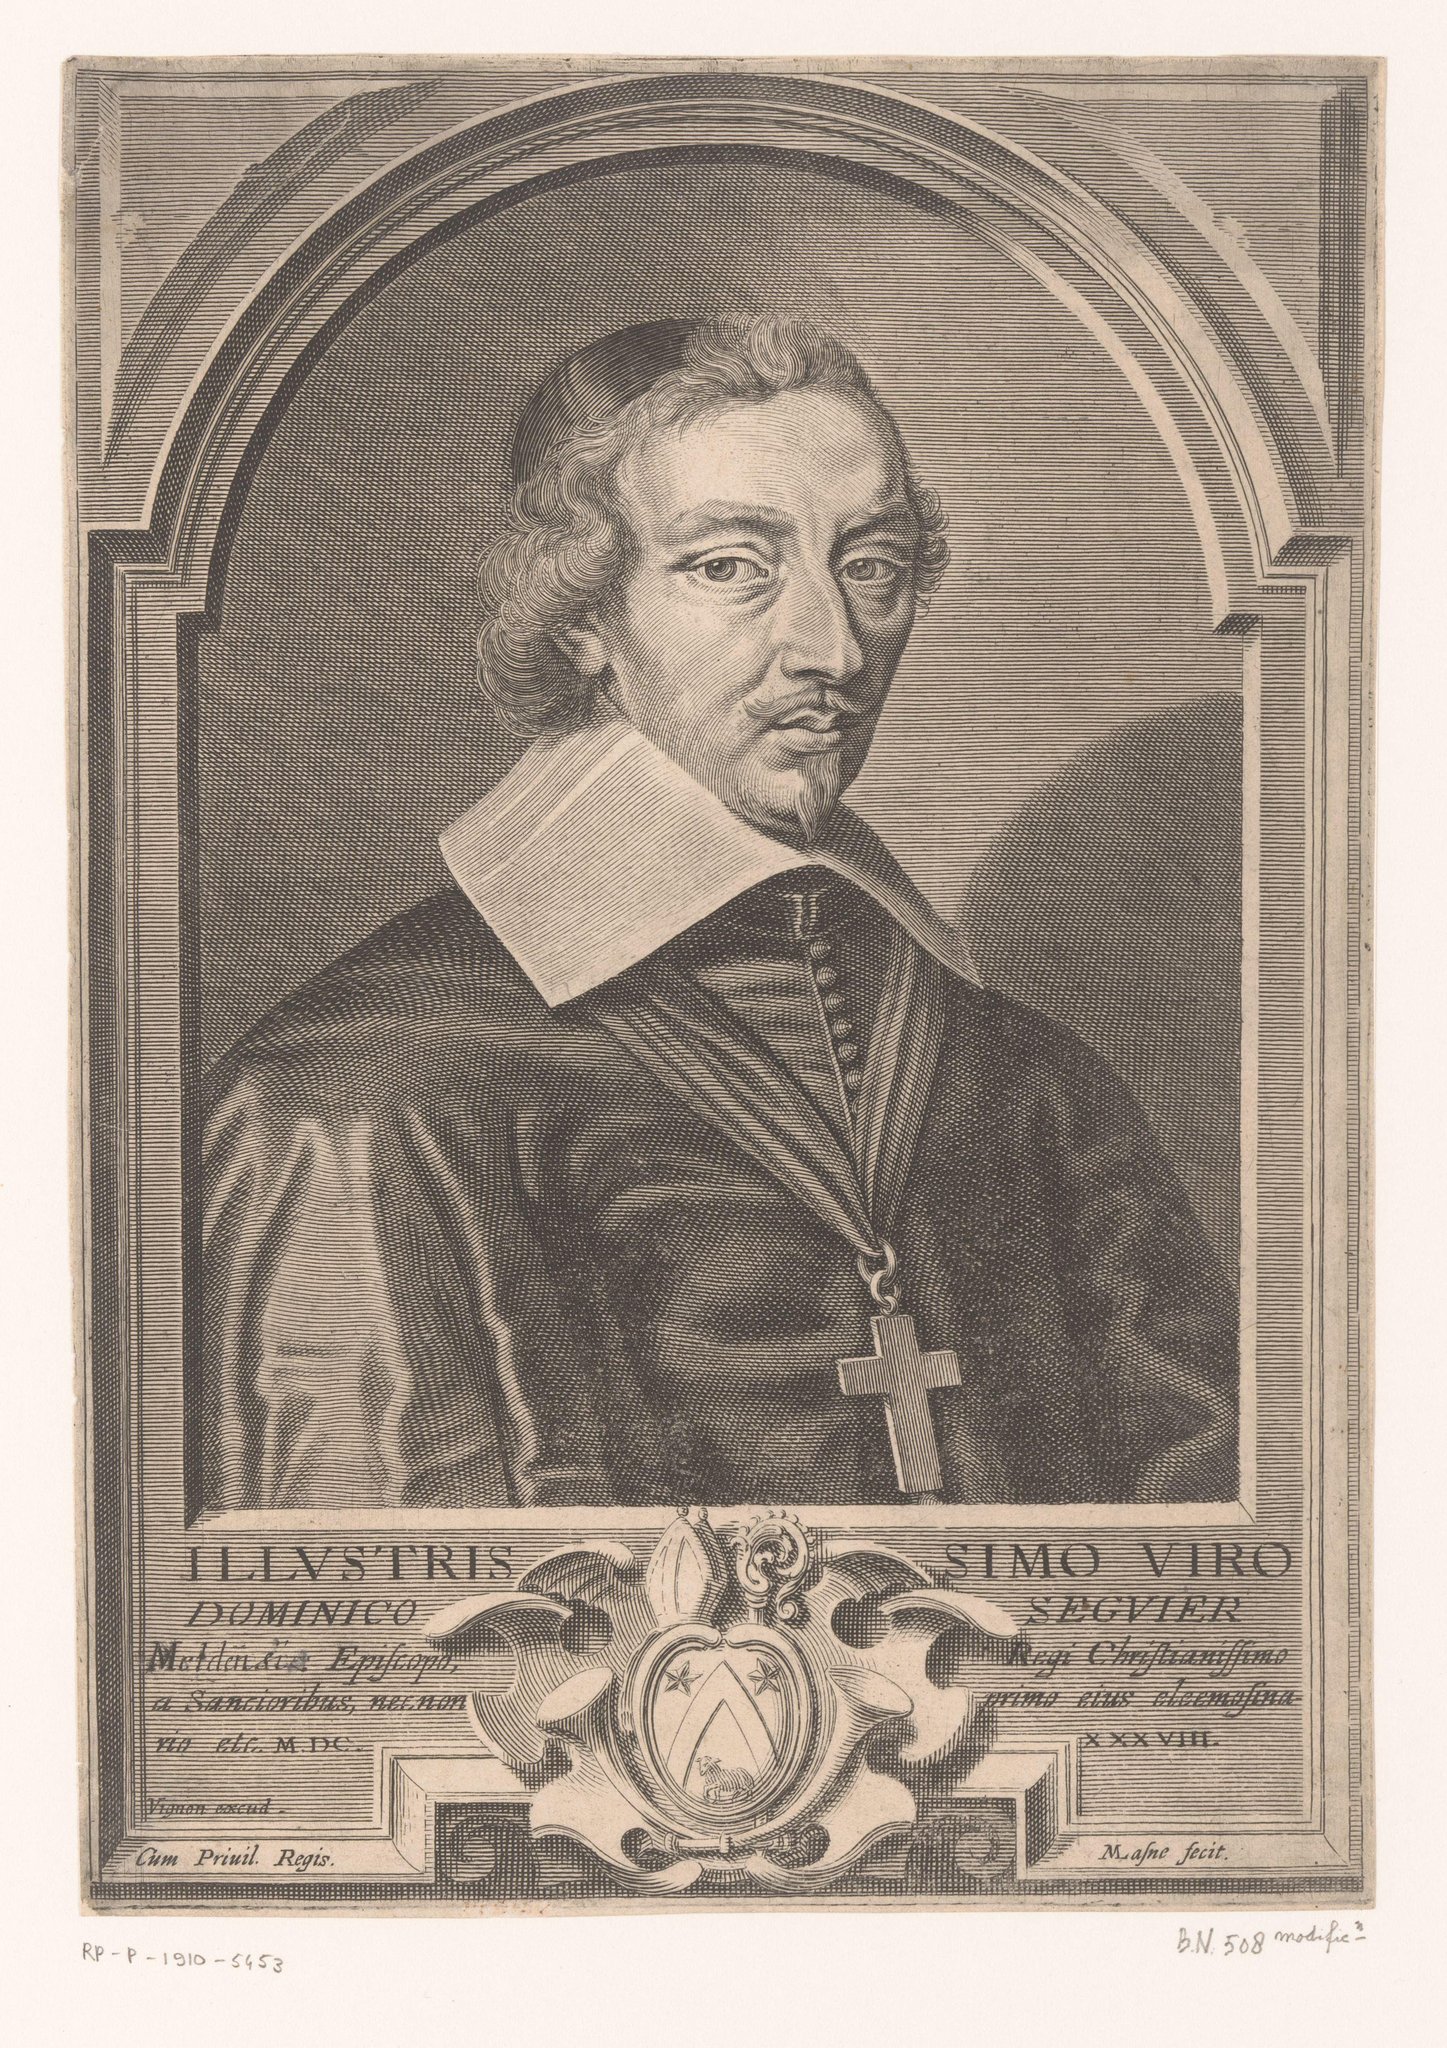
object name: print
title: Portret van Dominique Séguier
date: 1638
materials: paper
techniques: engraving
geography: france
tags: paris, dominique séguier, archbishop, bishop, etc. (roman catholic), historical persons, armorial bearing, heraldry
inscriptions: collector's mark: Lugt 2228